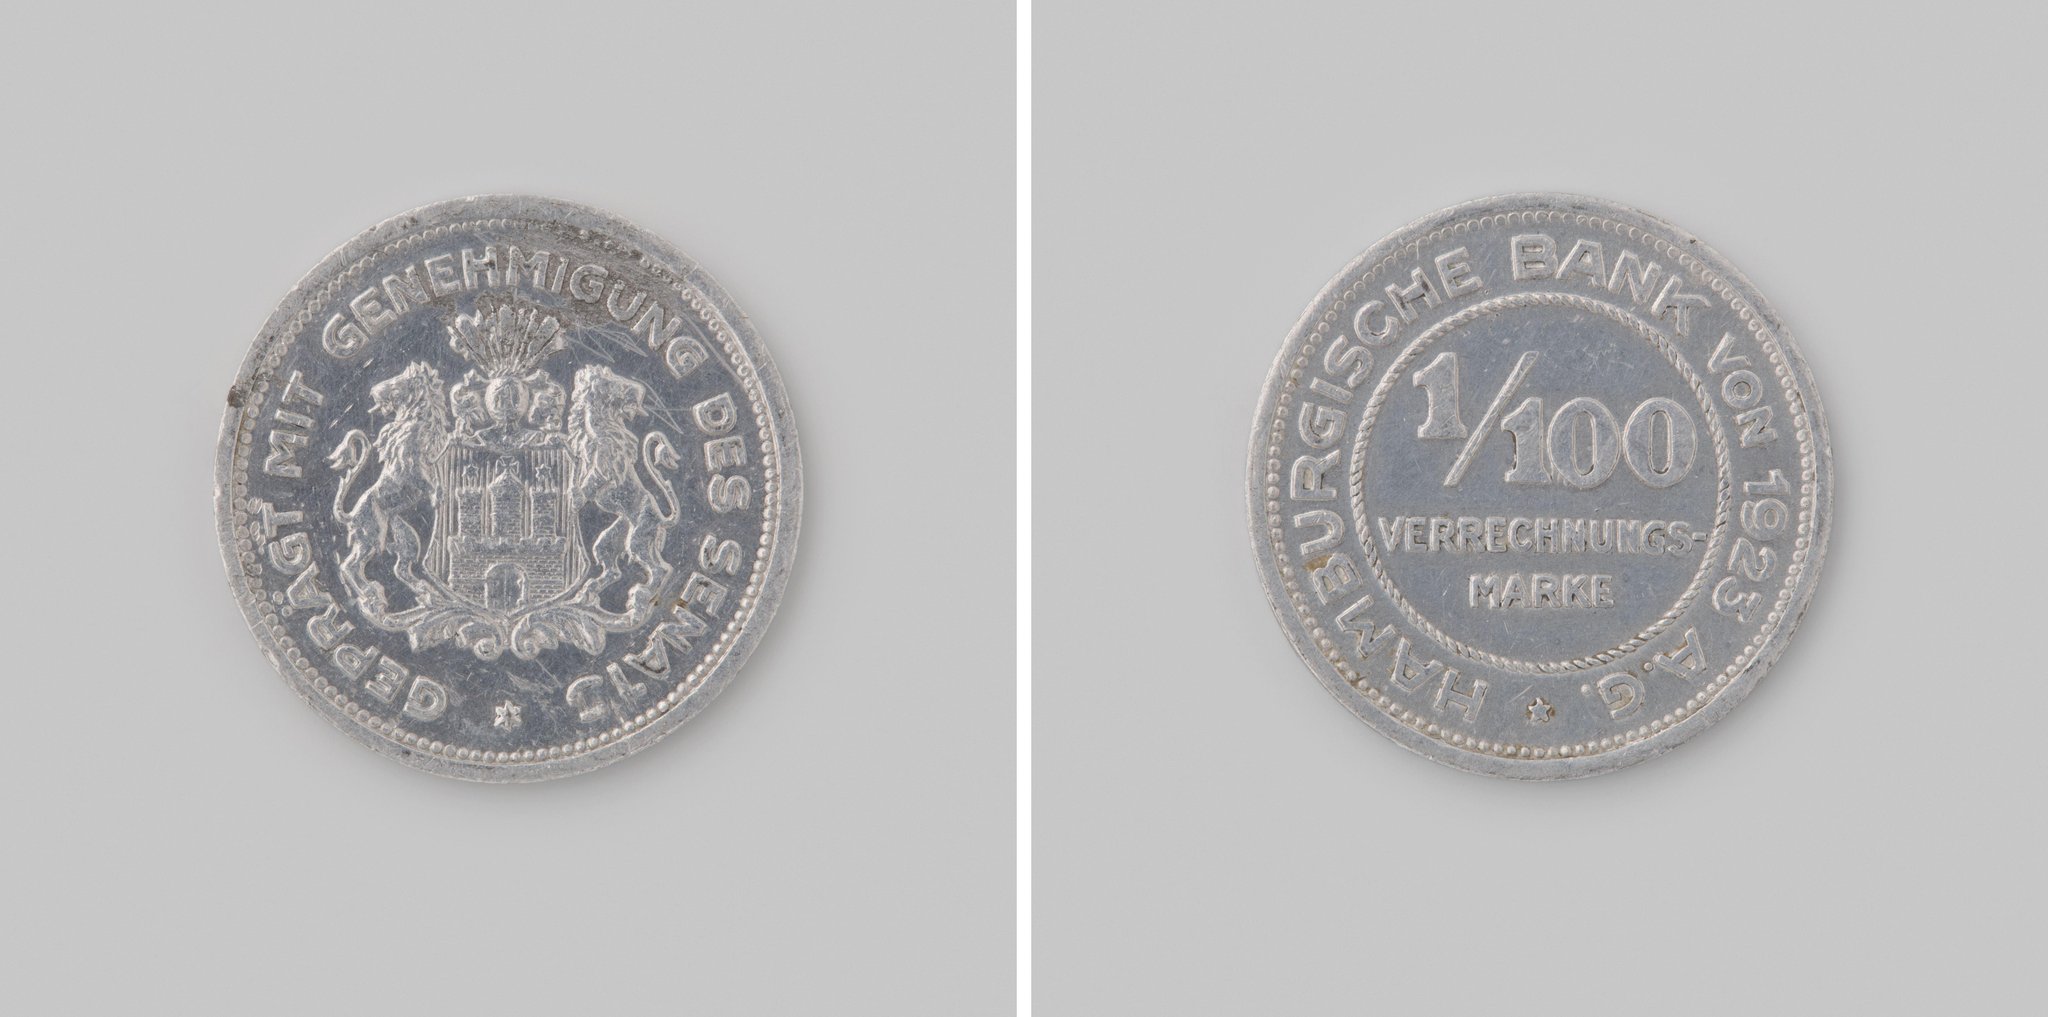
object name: siege coin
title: Een honderdste verrechnungsmarke uit Duitsland, noodmunt van Hamburg, 1923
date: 1923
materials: aluminum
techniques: striking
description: Aluminium noodmunt. Voorzijde: door twee leeuwen gehouden wapenschild van de stad. Keerzijde: waarde-aanduiding in drie regels. Aanduiding van de plaatselijke bank en jaartal in omschrift. Gladde rand.